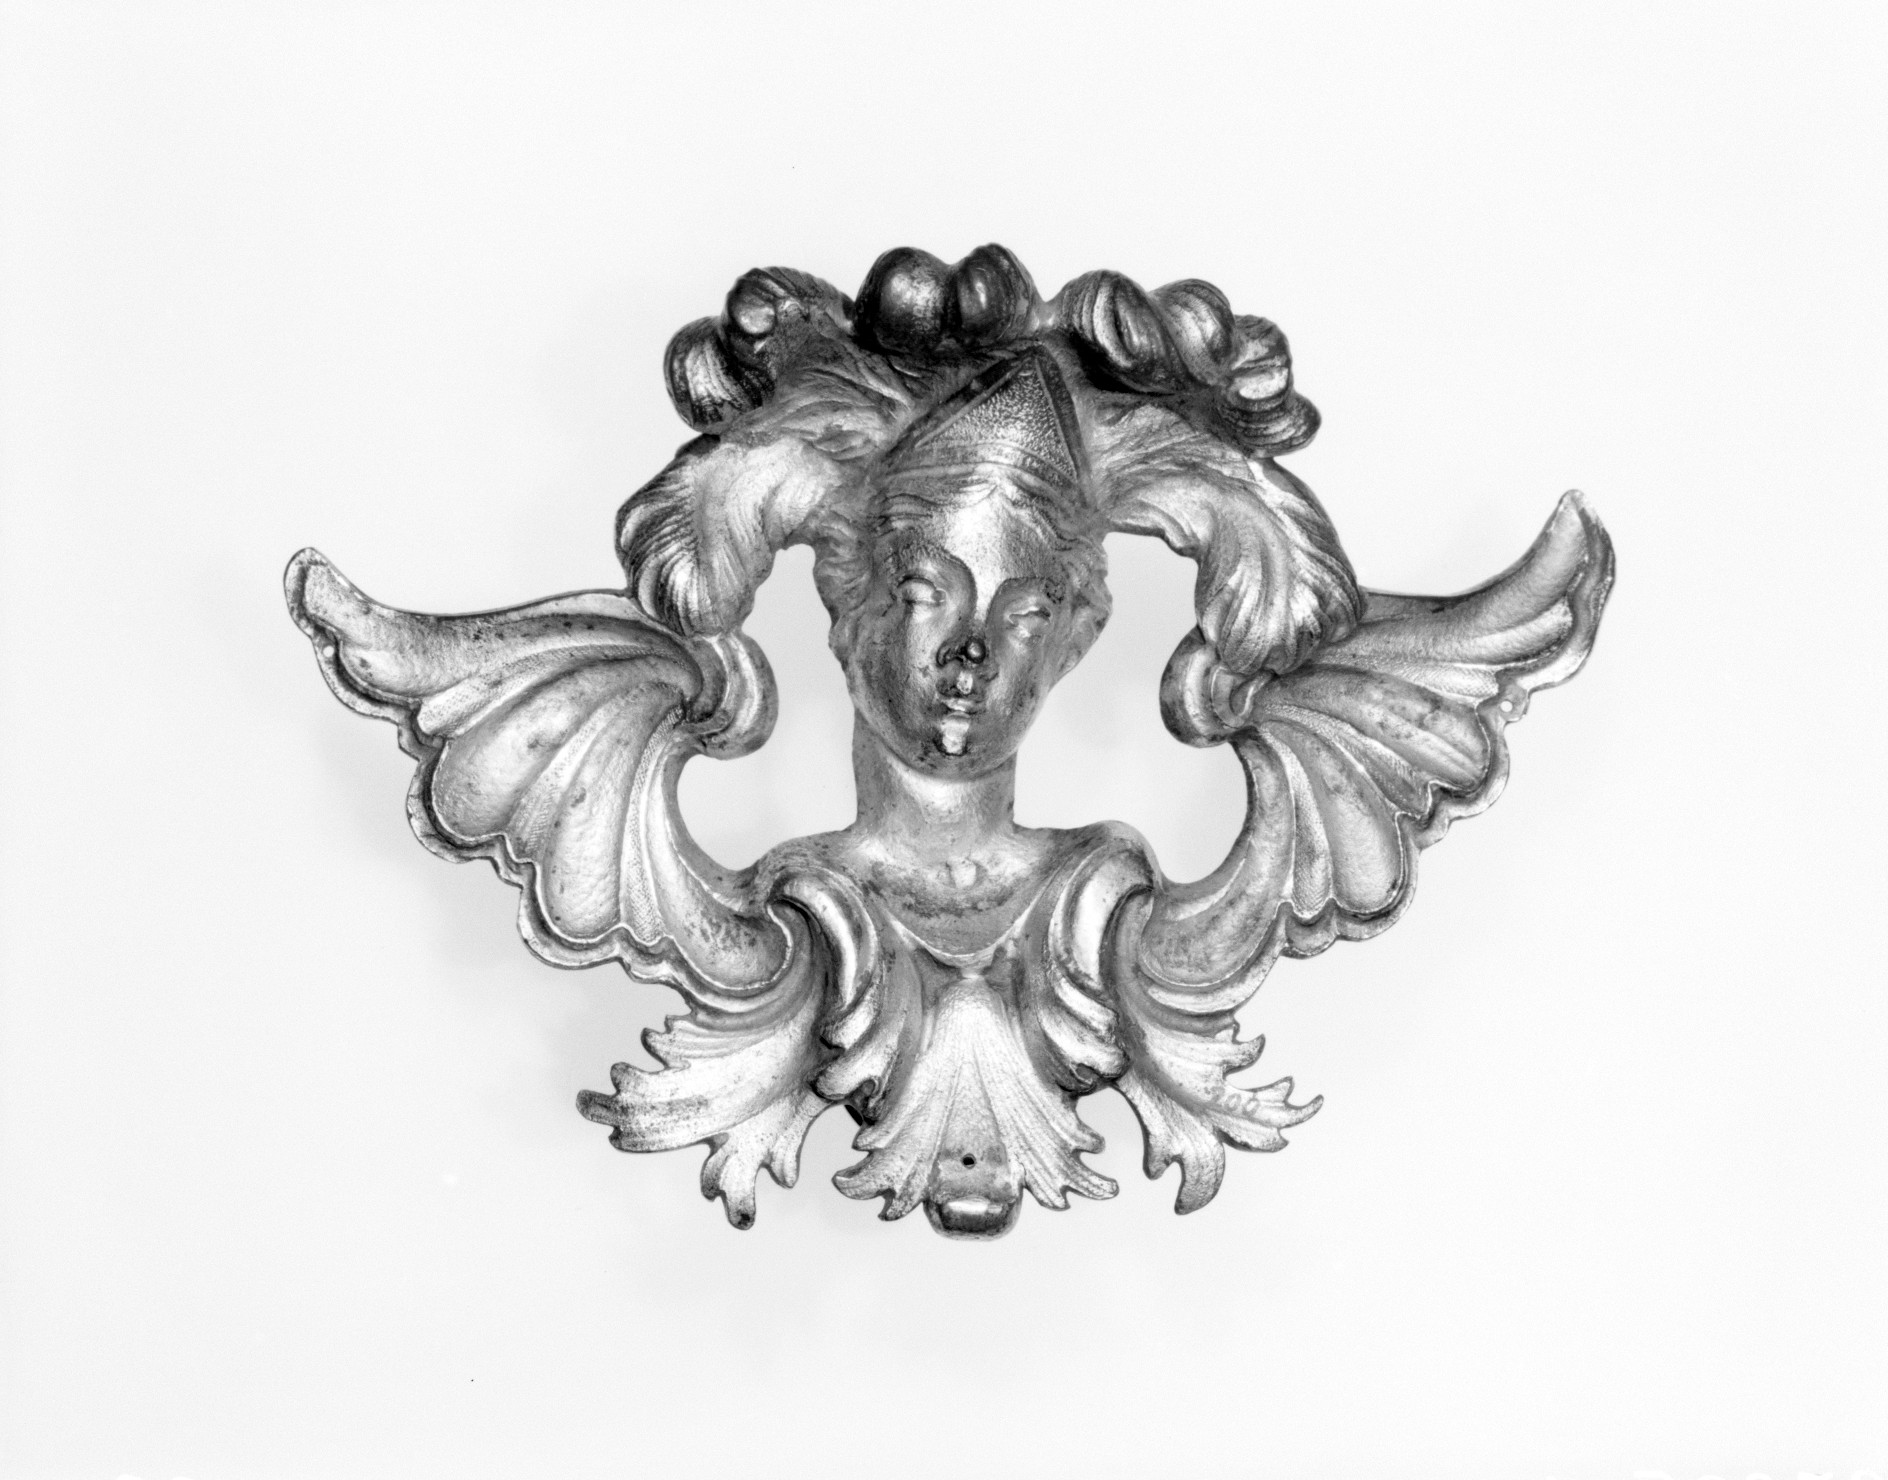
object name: apron ornament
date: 1701-1800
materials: gilt bronze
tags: women